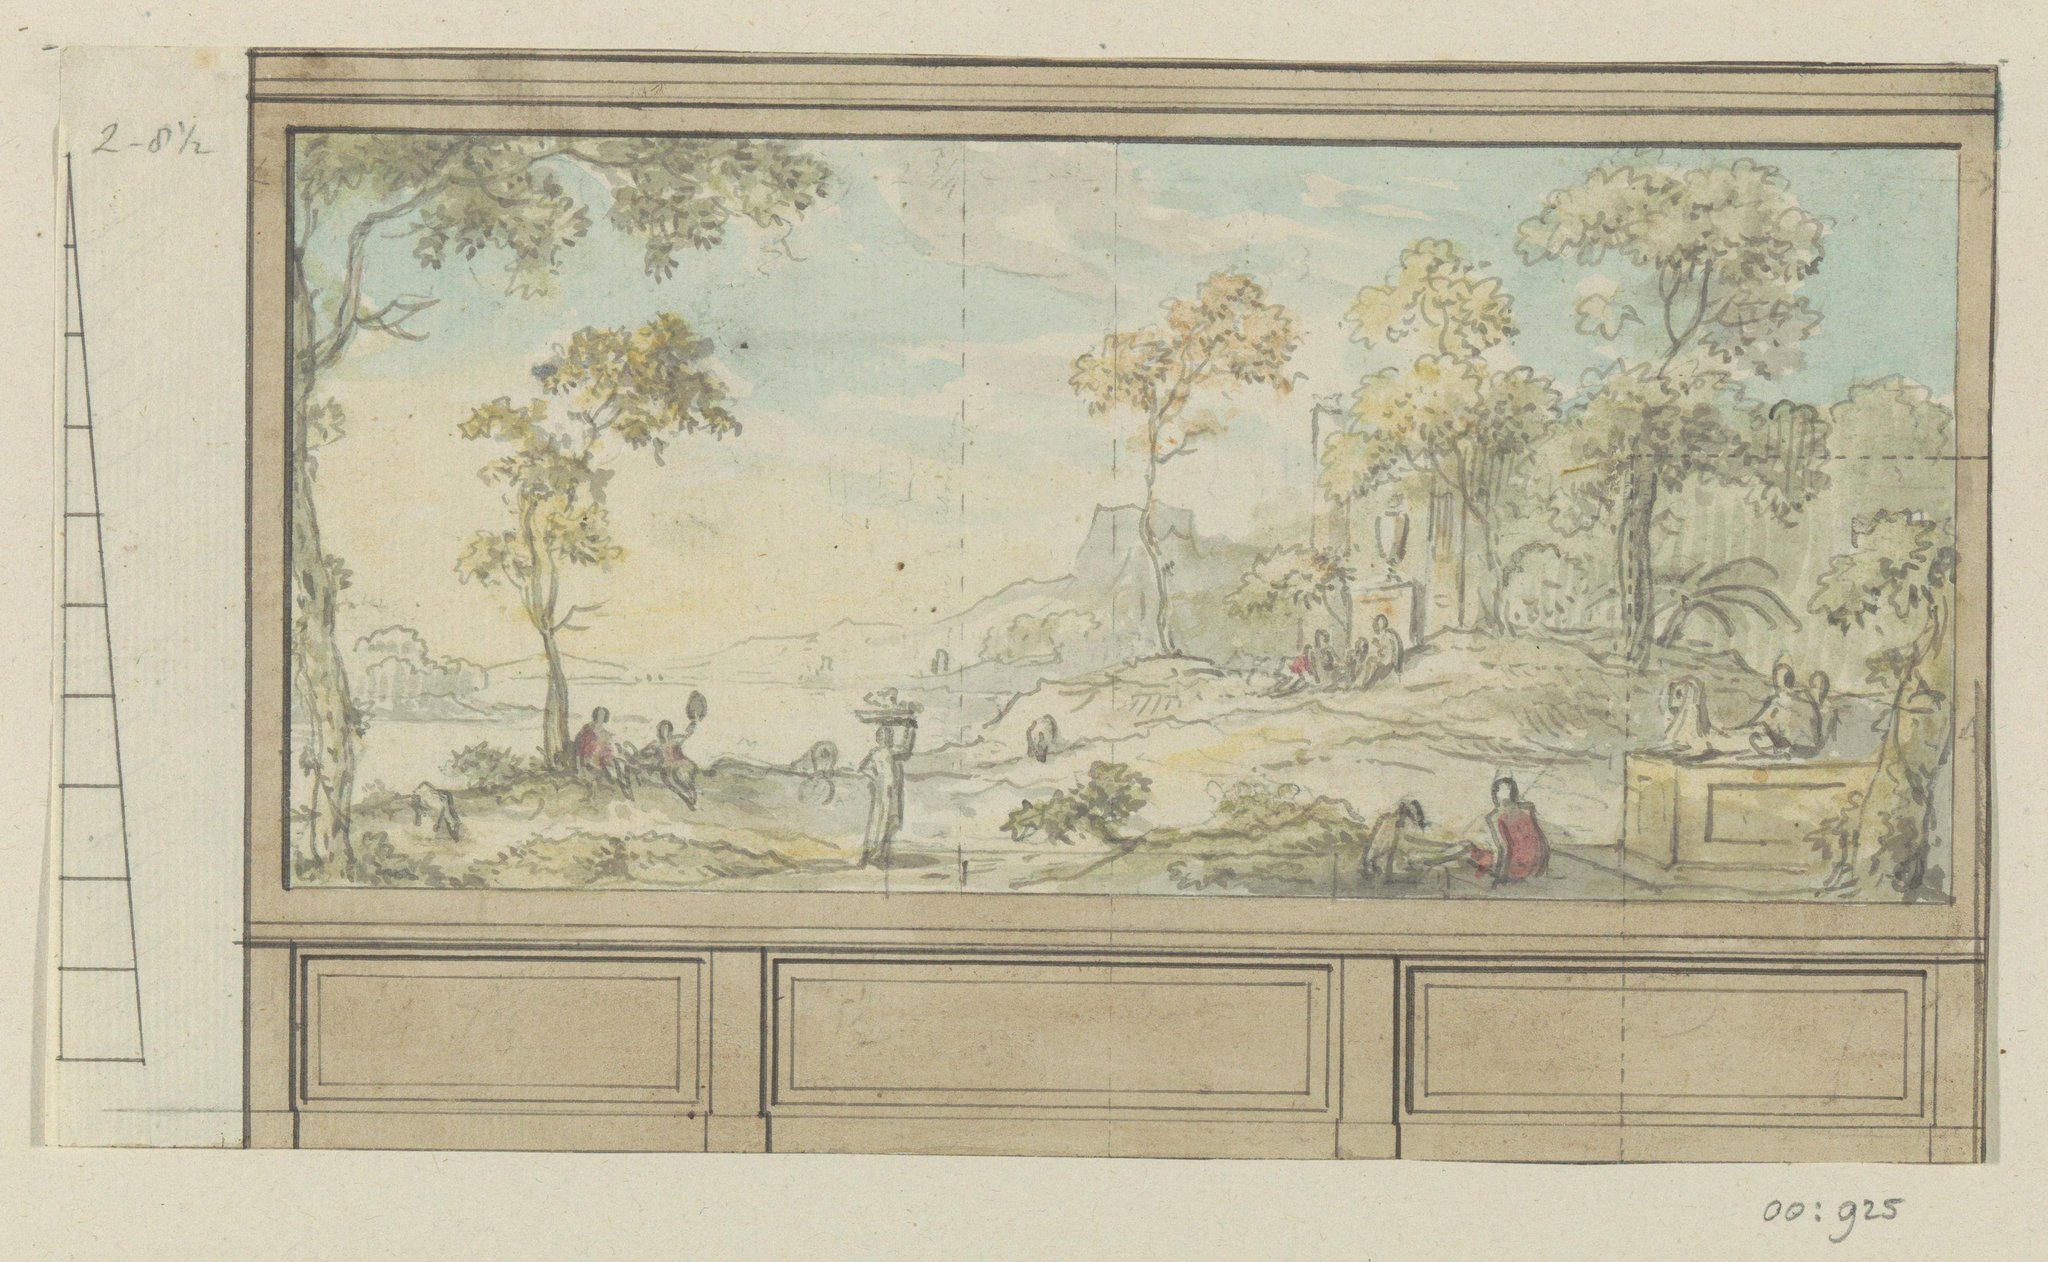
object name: album leaf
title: Ontwerptekening voor een kamerwand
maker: jurriaan andriessen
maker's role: draughtsman, painter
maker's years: 1742-1819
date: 1760-1819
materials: paint, paper, pencil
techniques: brush, pen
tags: trees, landscapes in the temperate zone, wall-covering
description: Met een arcadische voorstelling en links een schaalaanduiding. Tekening maakt deel uit van een album.